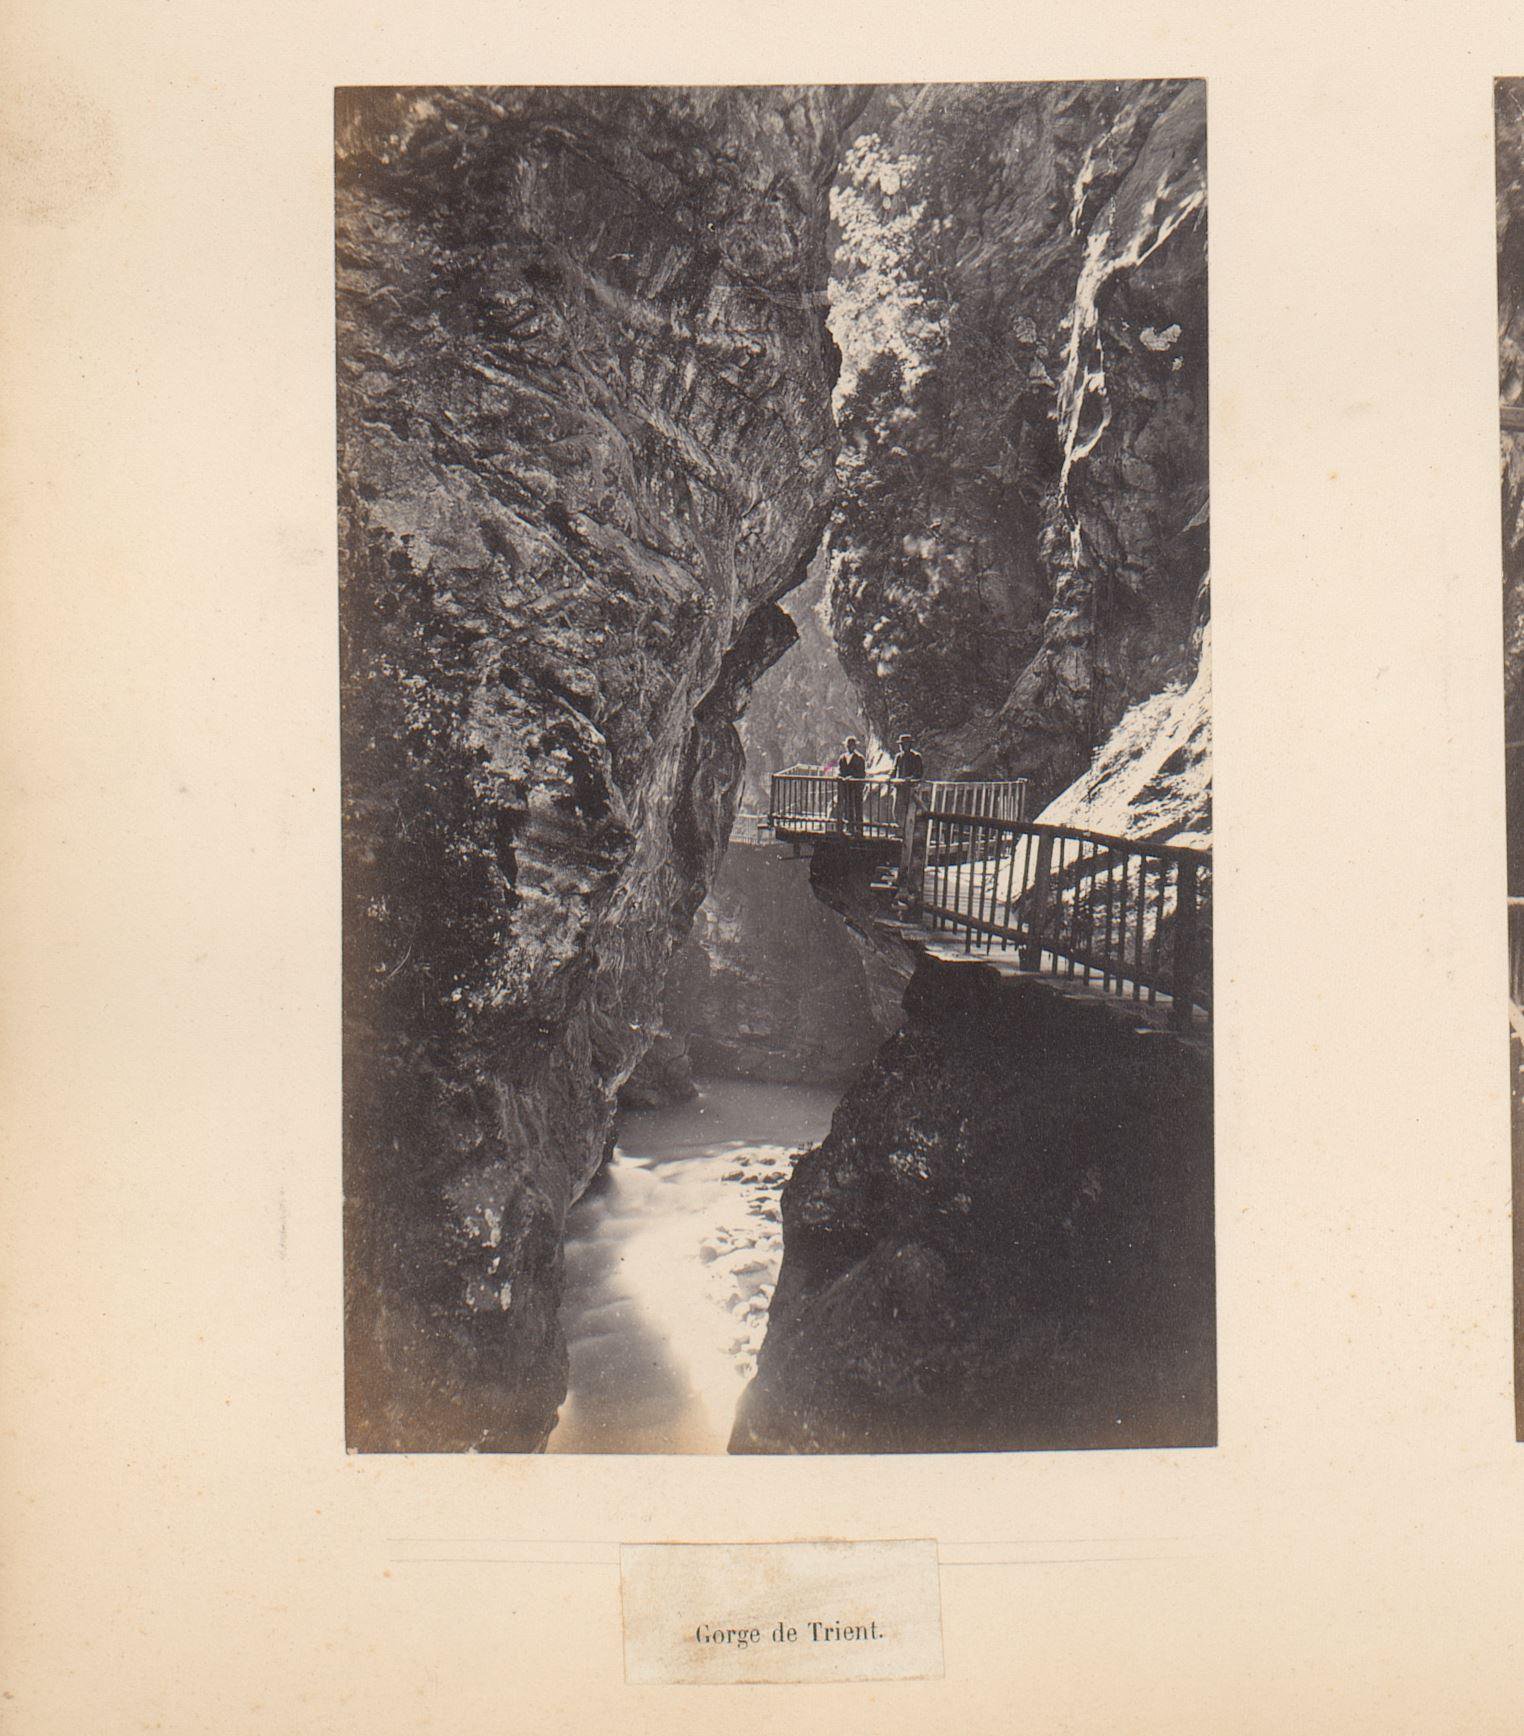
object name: photograph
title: Twee mensen op het pad door de Trientkloof, Zwitserland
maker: Anonymous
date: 1860-1890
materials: paper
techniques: albumen print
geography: wallis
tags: adult man (+ two persons), ravine, chasm, abyss, canyon, brook